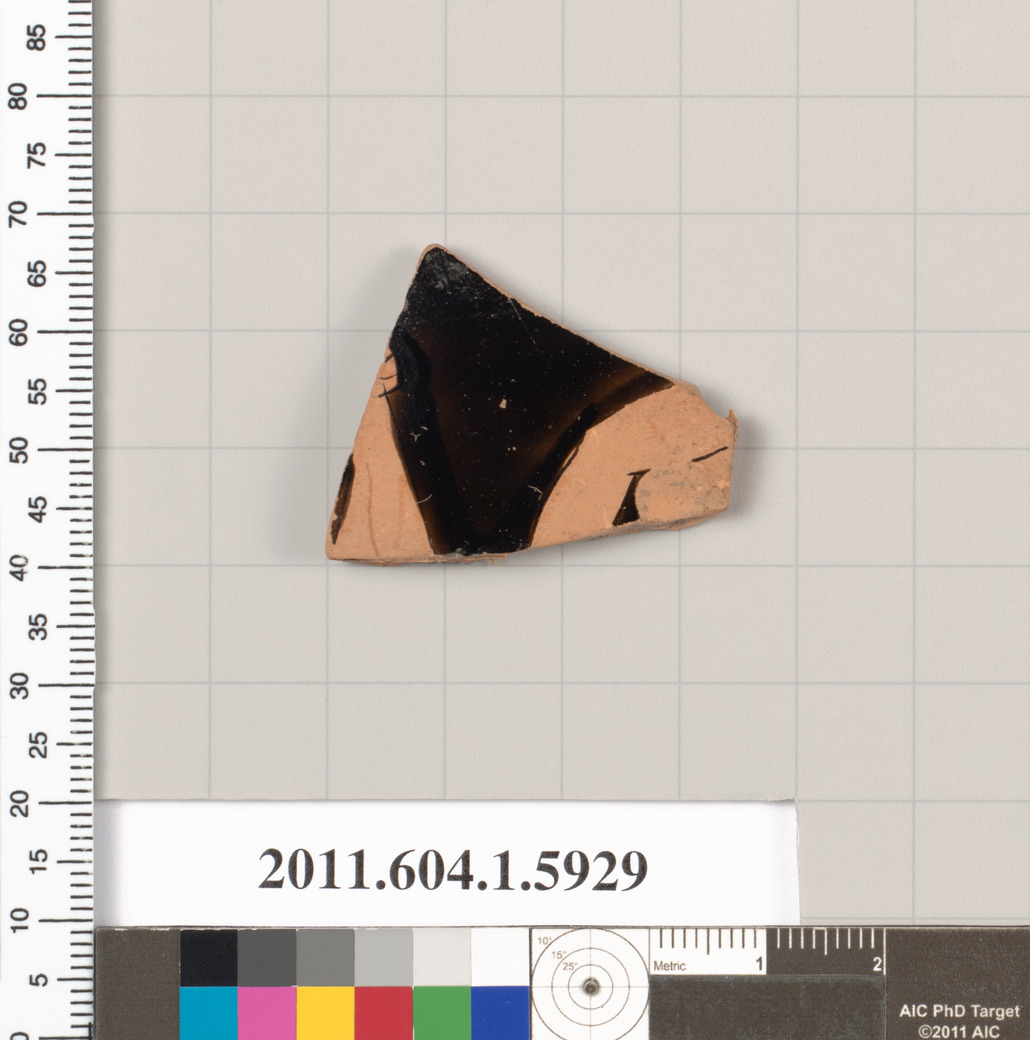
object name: kylix fragment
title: Terracotta fragment of a kylix (drinking cup)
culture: greek, attic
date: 520-510 BCE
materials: terracotta